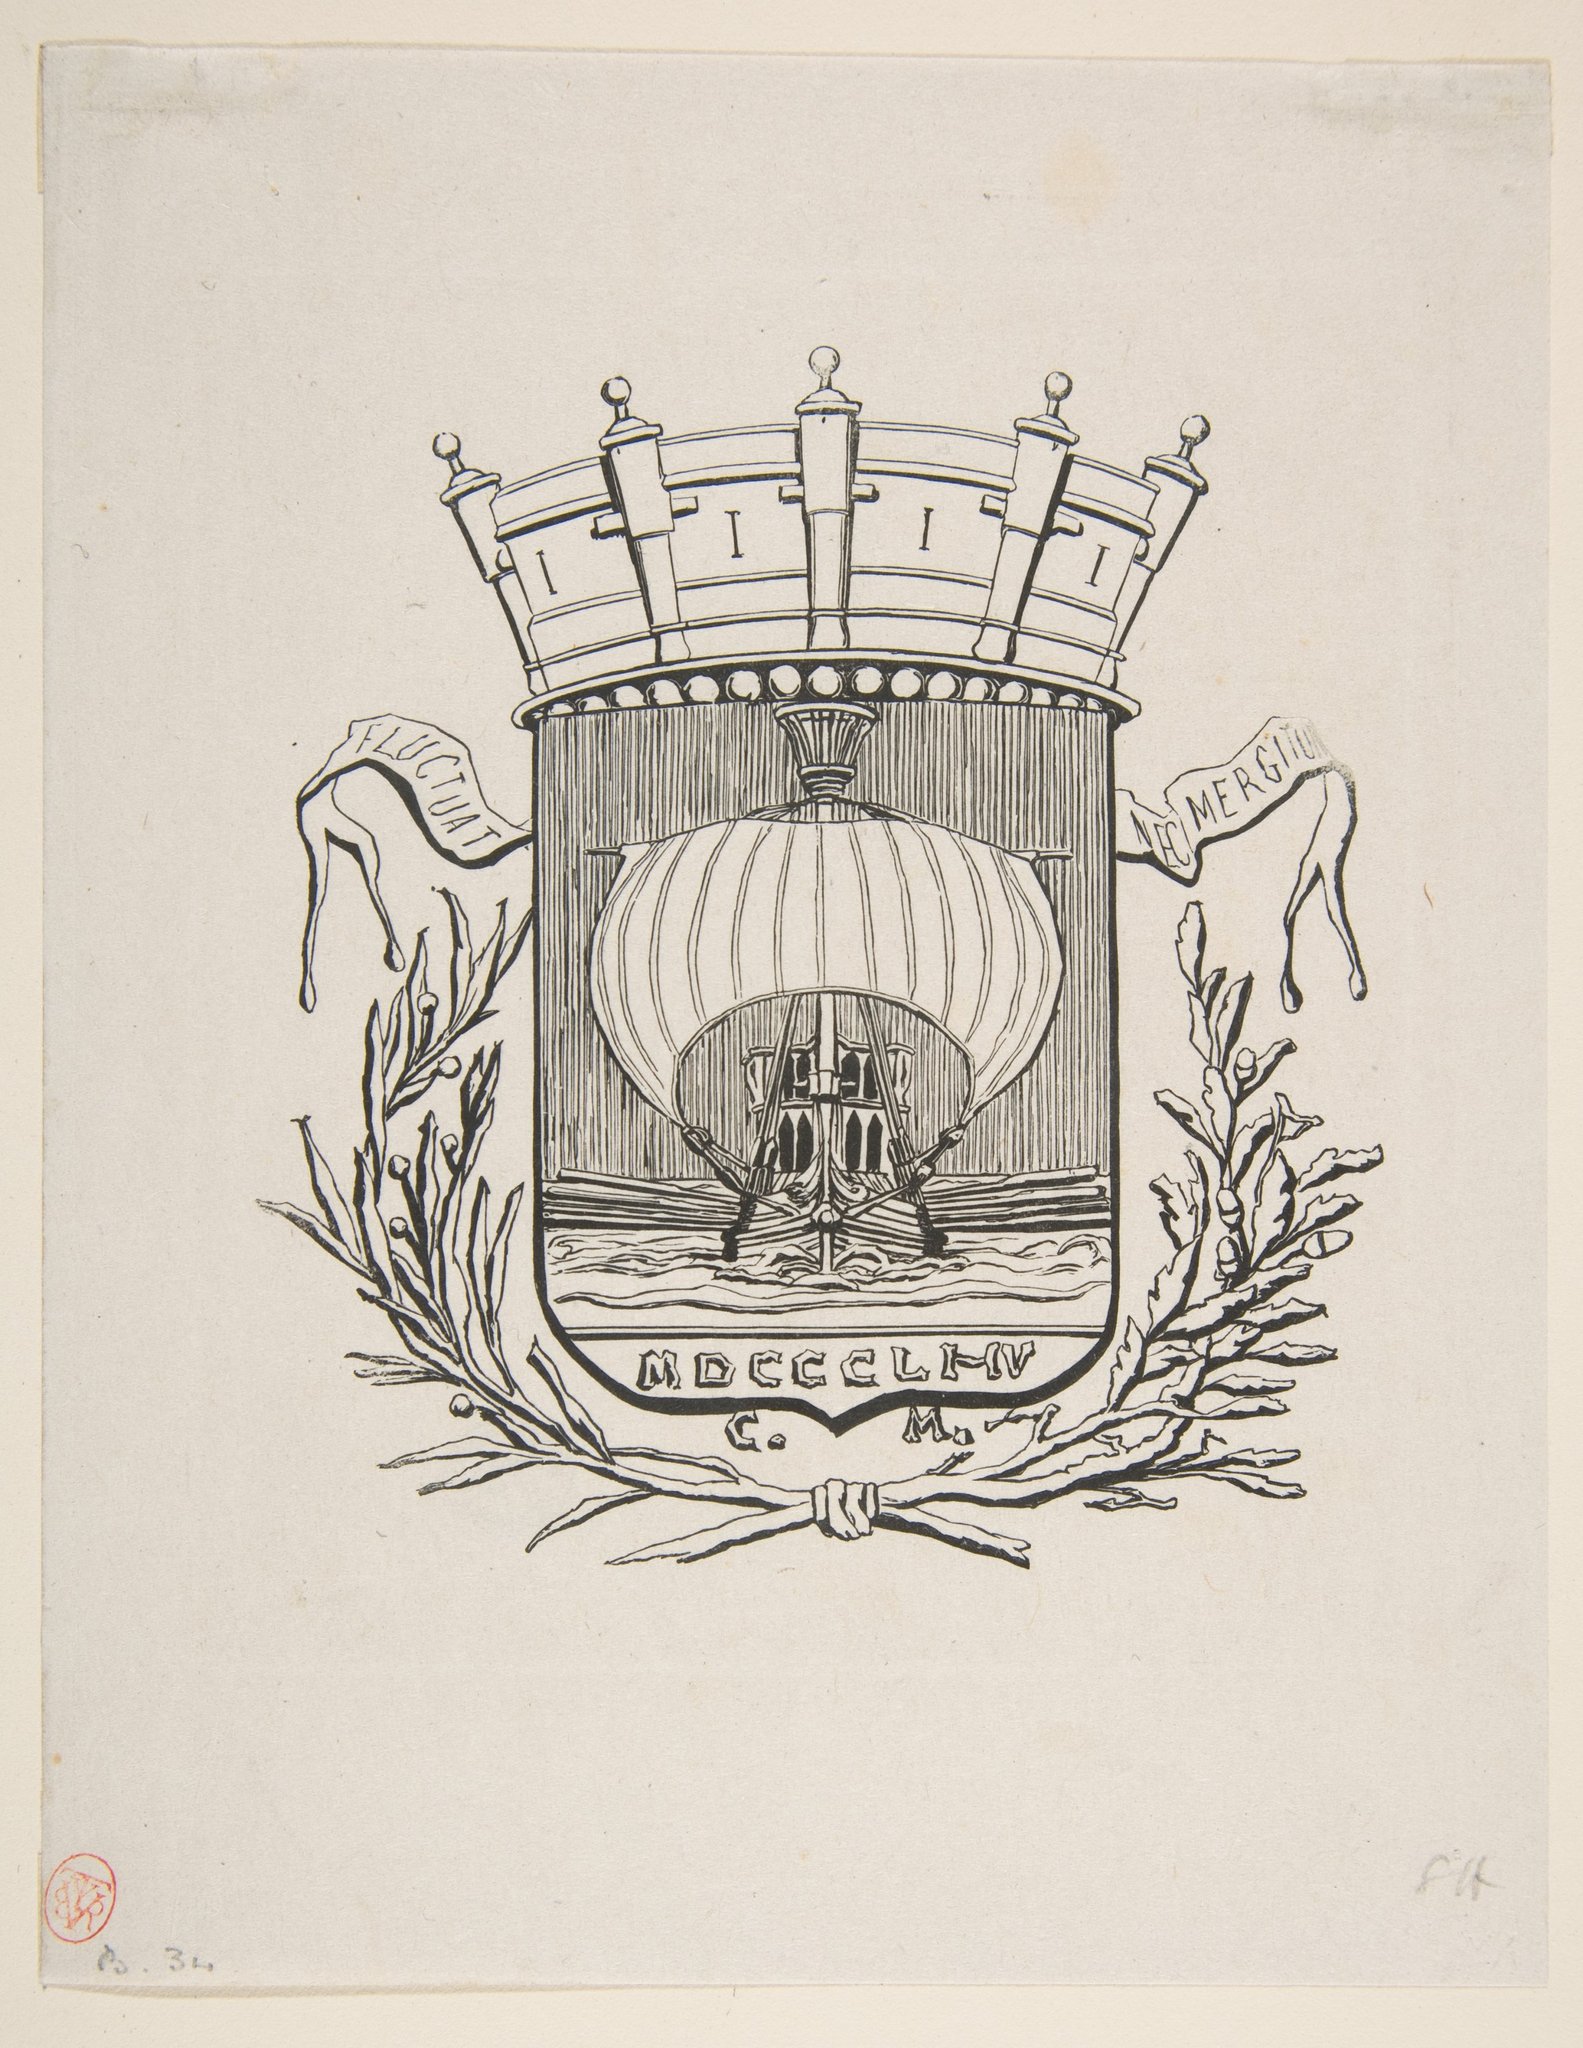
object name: print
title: Coat-of-Arms Symbolic of the City of Paris with the motto: It Rocks But Does Not Sink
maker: charles meryon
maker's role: artist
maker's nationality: french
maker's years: 1821-1868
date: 1854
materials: paper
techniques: woodcut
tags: coat of arms